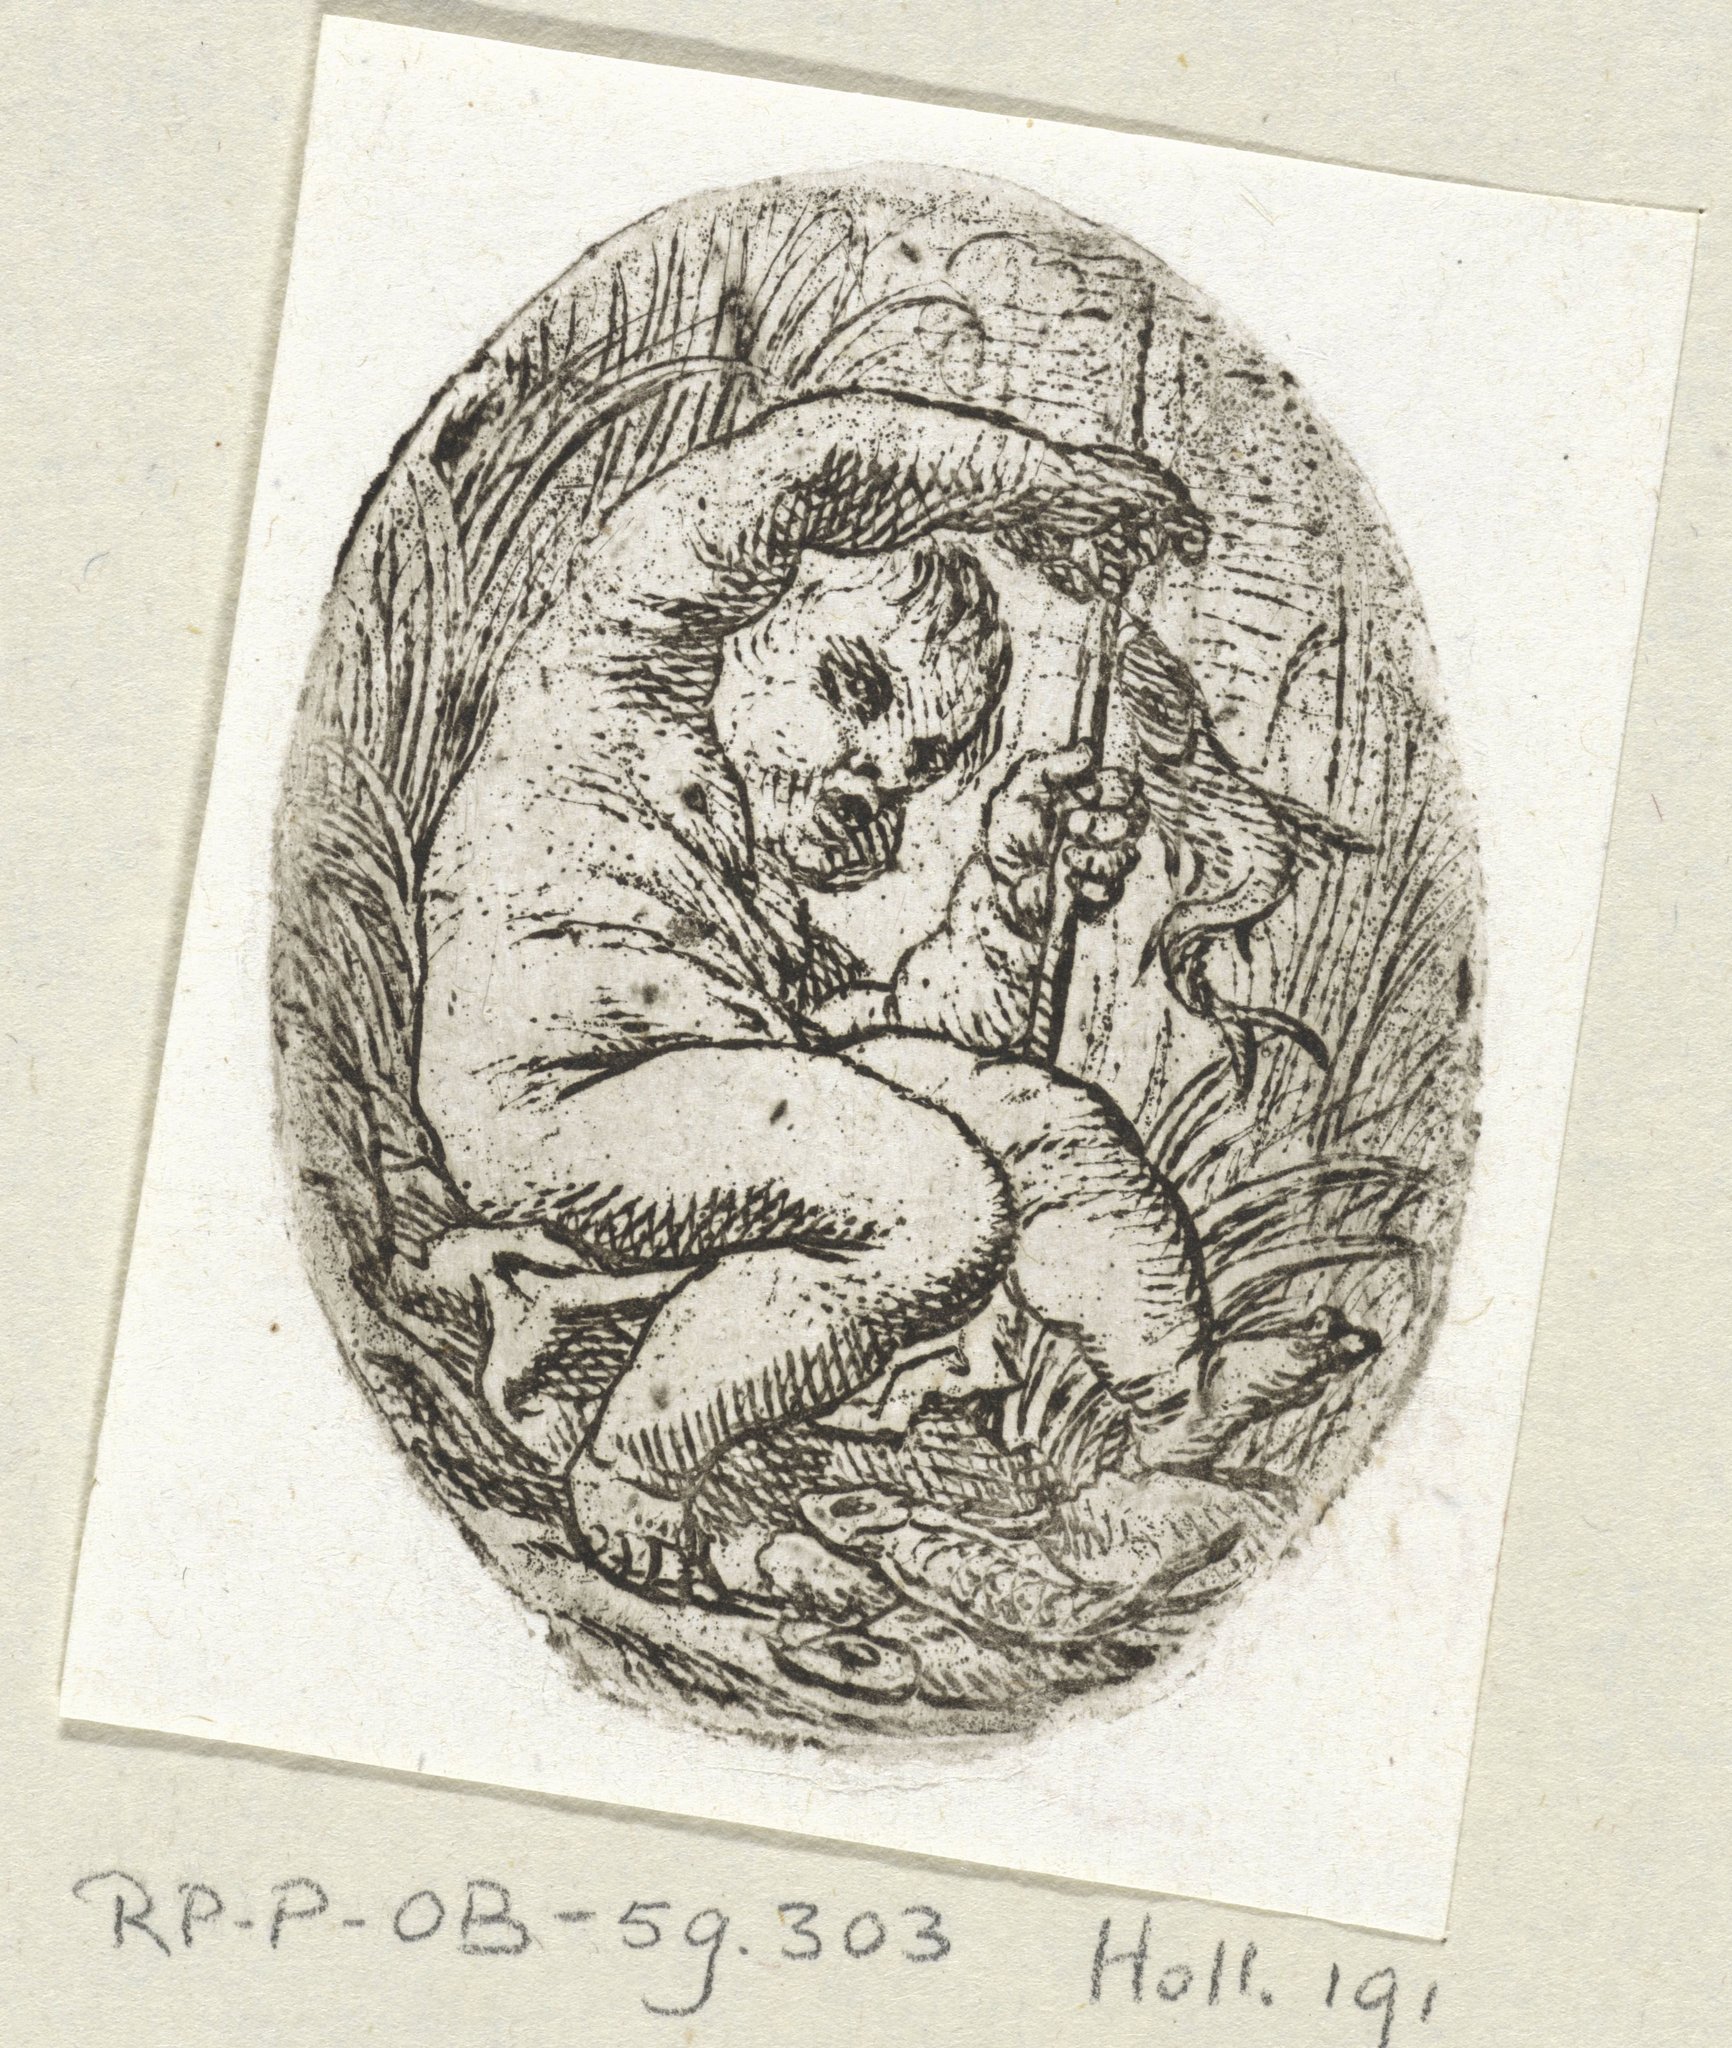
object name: print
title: Putto die een vis van de haak haalt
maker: cornelis schut (i)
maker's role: draughtsman, print maker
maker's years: 1597-1655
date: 1618-1655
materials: paper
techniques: etching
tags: fishing (sports)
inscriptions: collector's mark: Lugt 240